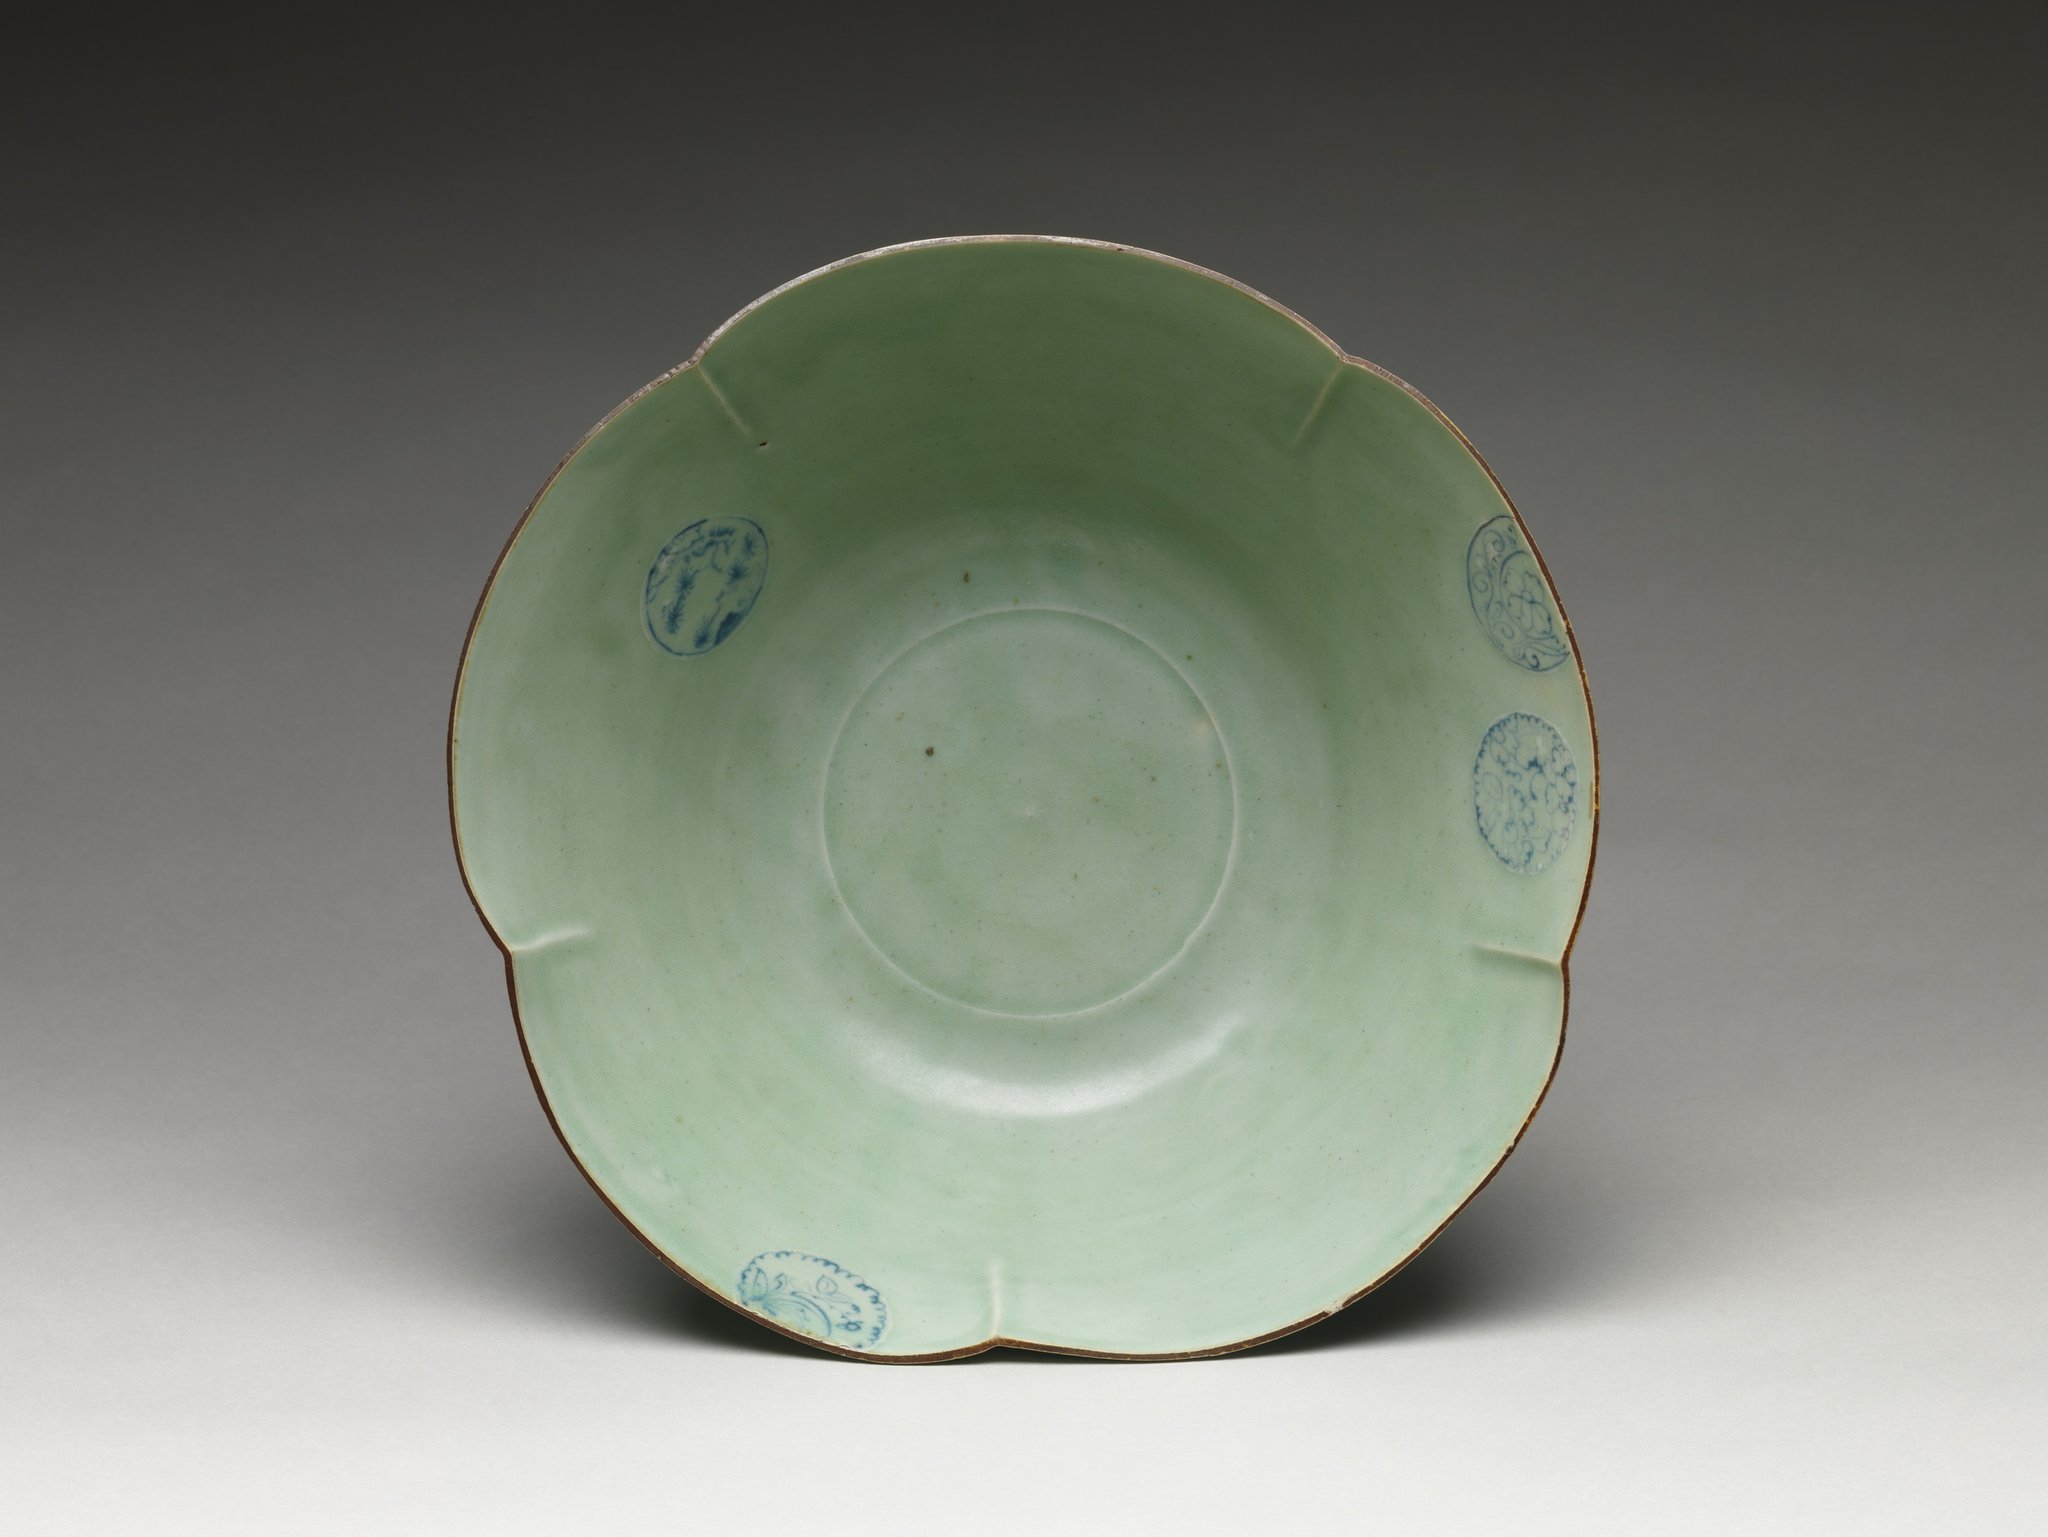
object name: bowl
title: Large Bowl with Floral Design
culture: japanese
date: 1615-1868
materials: ceramic glaze, glaze, porcelain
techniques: underglaze